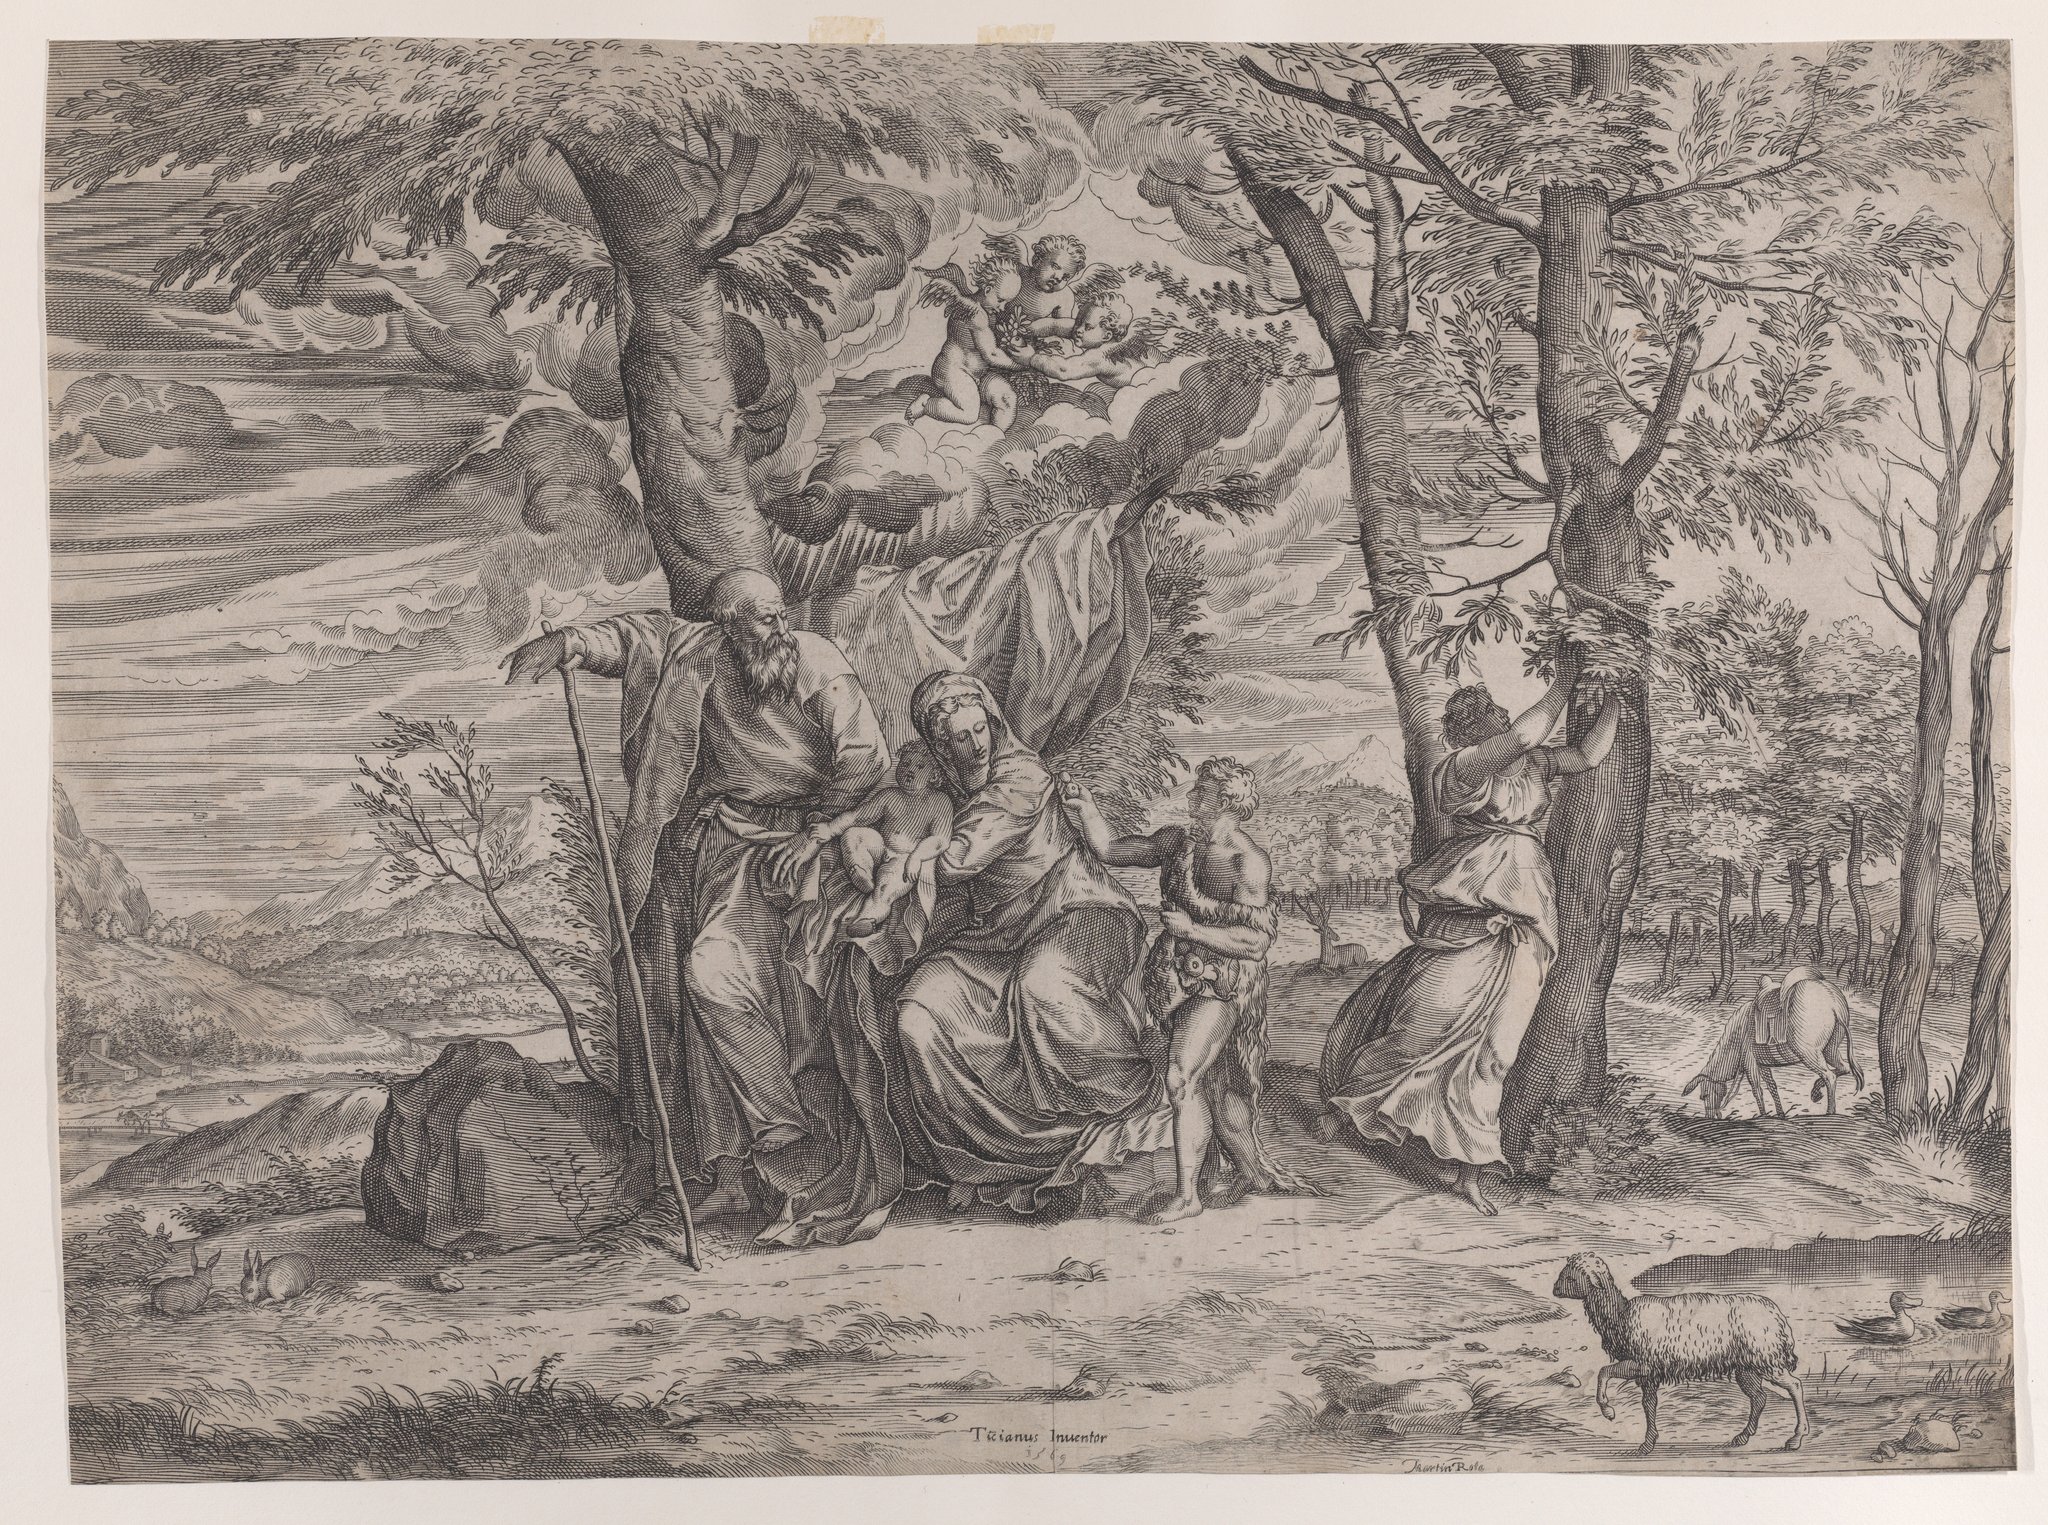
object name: print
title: The rest on the flight into Egypt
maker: martino rota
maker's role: artist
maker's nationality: italian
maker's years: 1520-1583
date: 1569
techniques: engraving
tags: men,trees,angels,saint peter